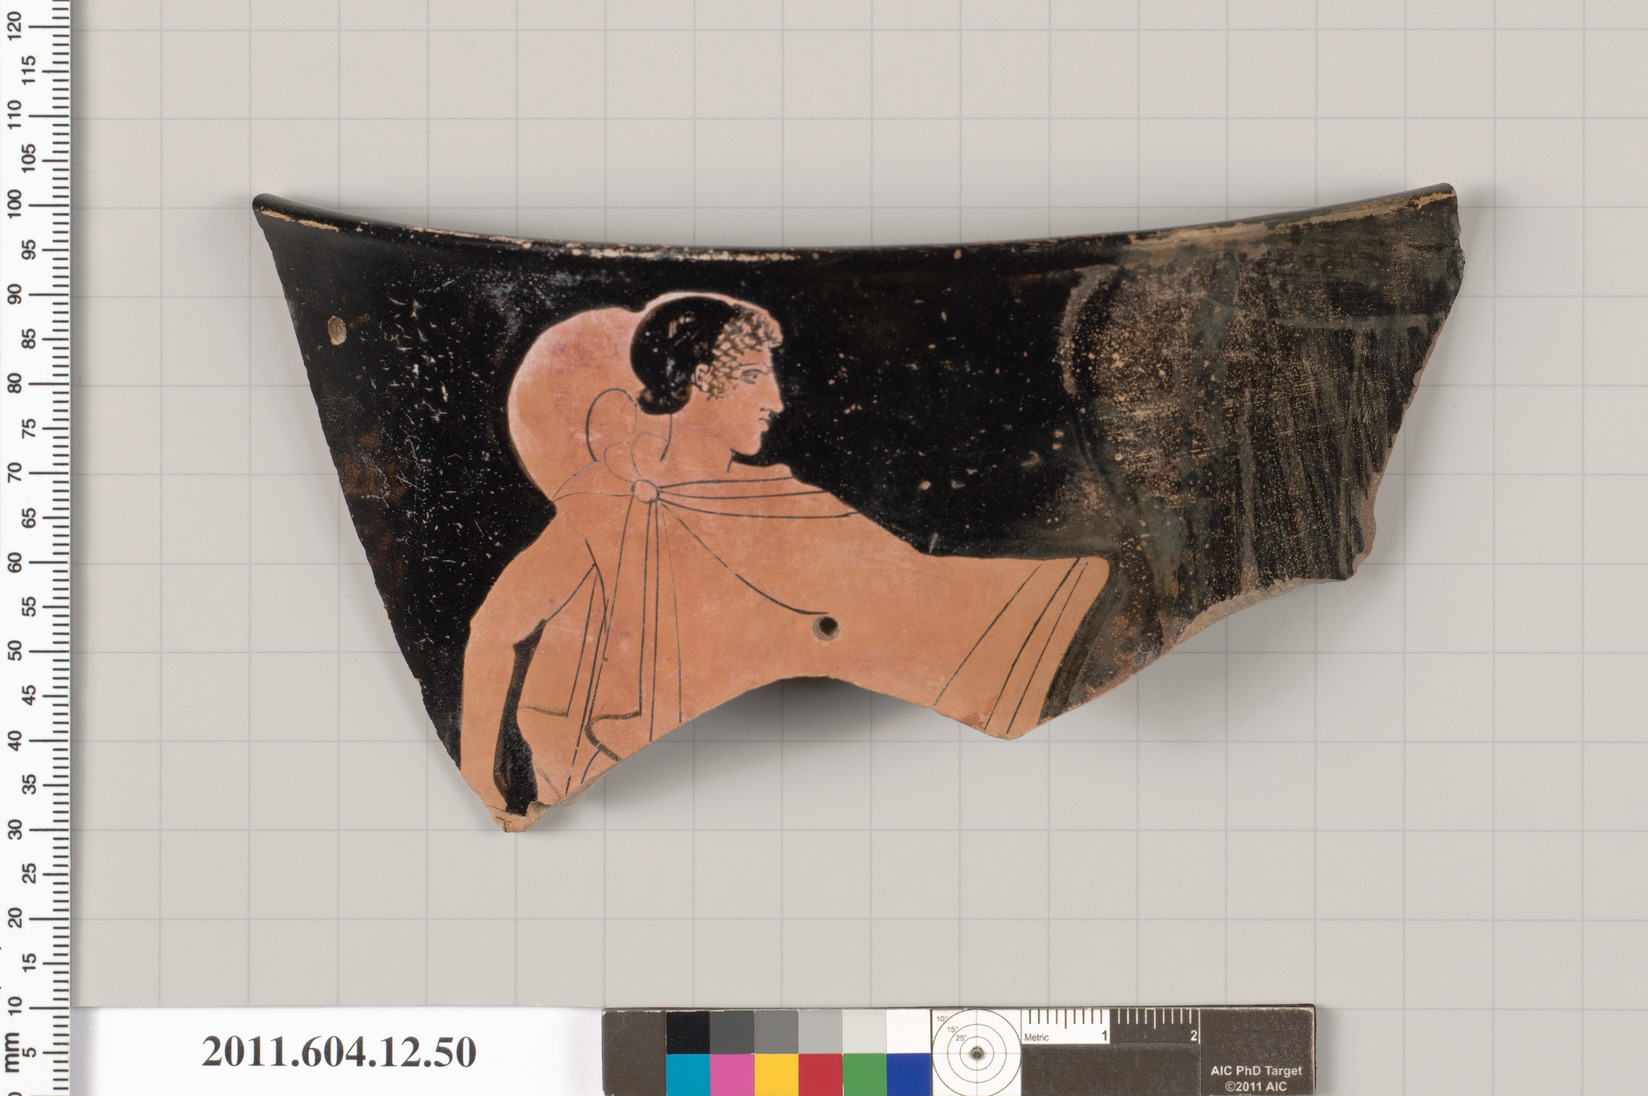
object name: skyphos fragment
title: Terracotta rim fragment of a skyphos (deep drinking cup)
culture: greek or south italian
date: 400-301 BCE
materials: terracotta